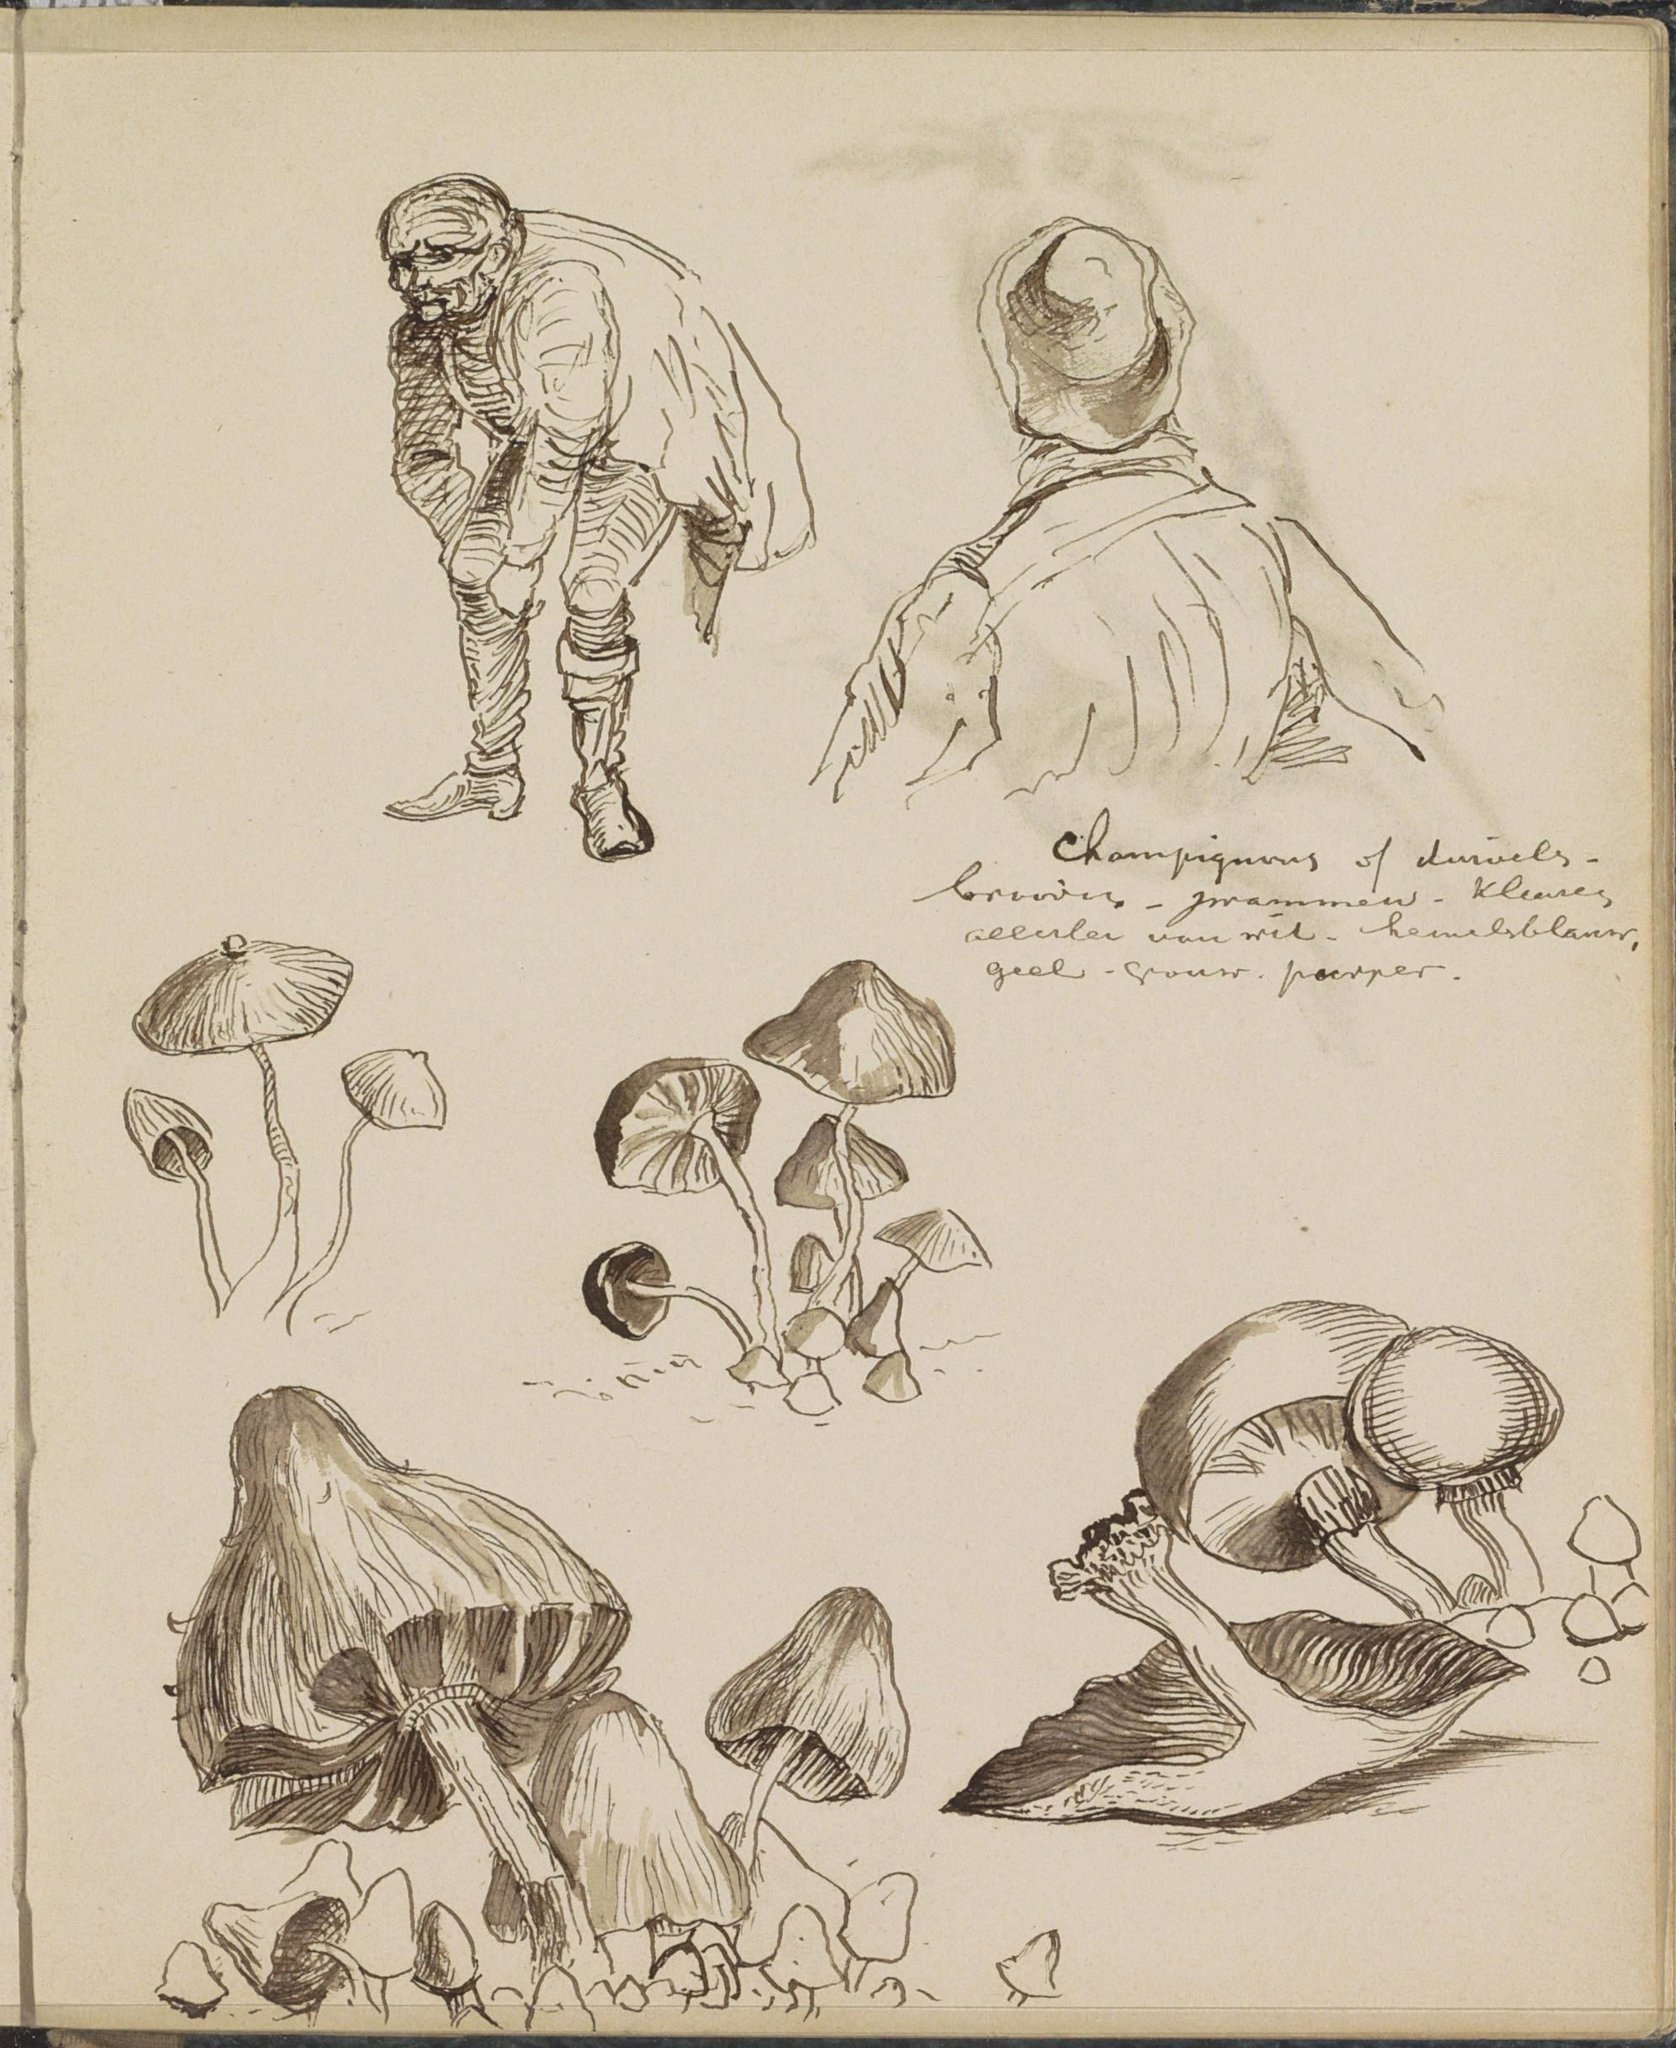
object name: sketchbook leaf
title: Paddenstoelen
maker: johannes tavenraat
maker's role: draughtsman, painter, print maker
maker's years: 1809-1881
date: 1841-1853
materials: ink, paper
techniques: brush, pen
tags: bending figure, head-gear: hat, mushrooms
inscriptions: annotation: ‘champignon of duivels-/ brooden- [...]mmens kleeves/ [...]eerler van wit- hemelsblauw,/ geel- groen . purper’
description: Tevens studies van een bukkende man die zijn laars optrekt en een man met hoed, van achter gezien. Blad 78 recto uit een schetsboek met 87 bladen.